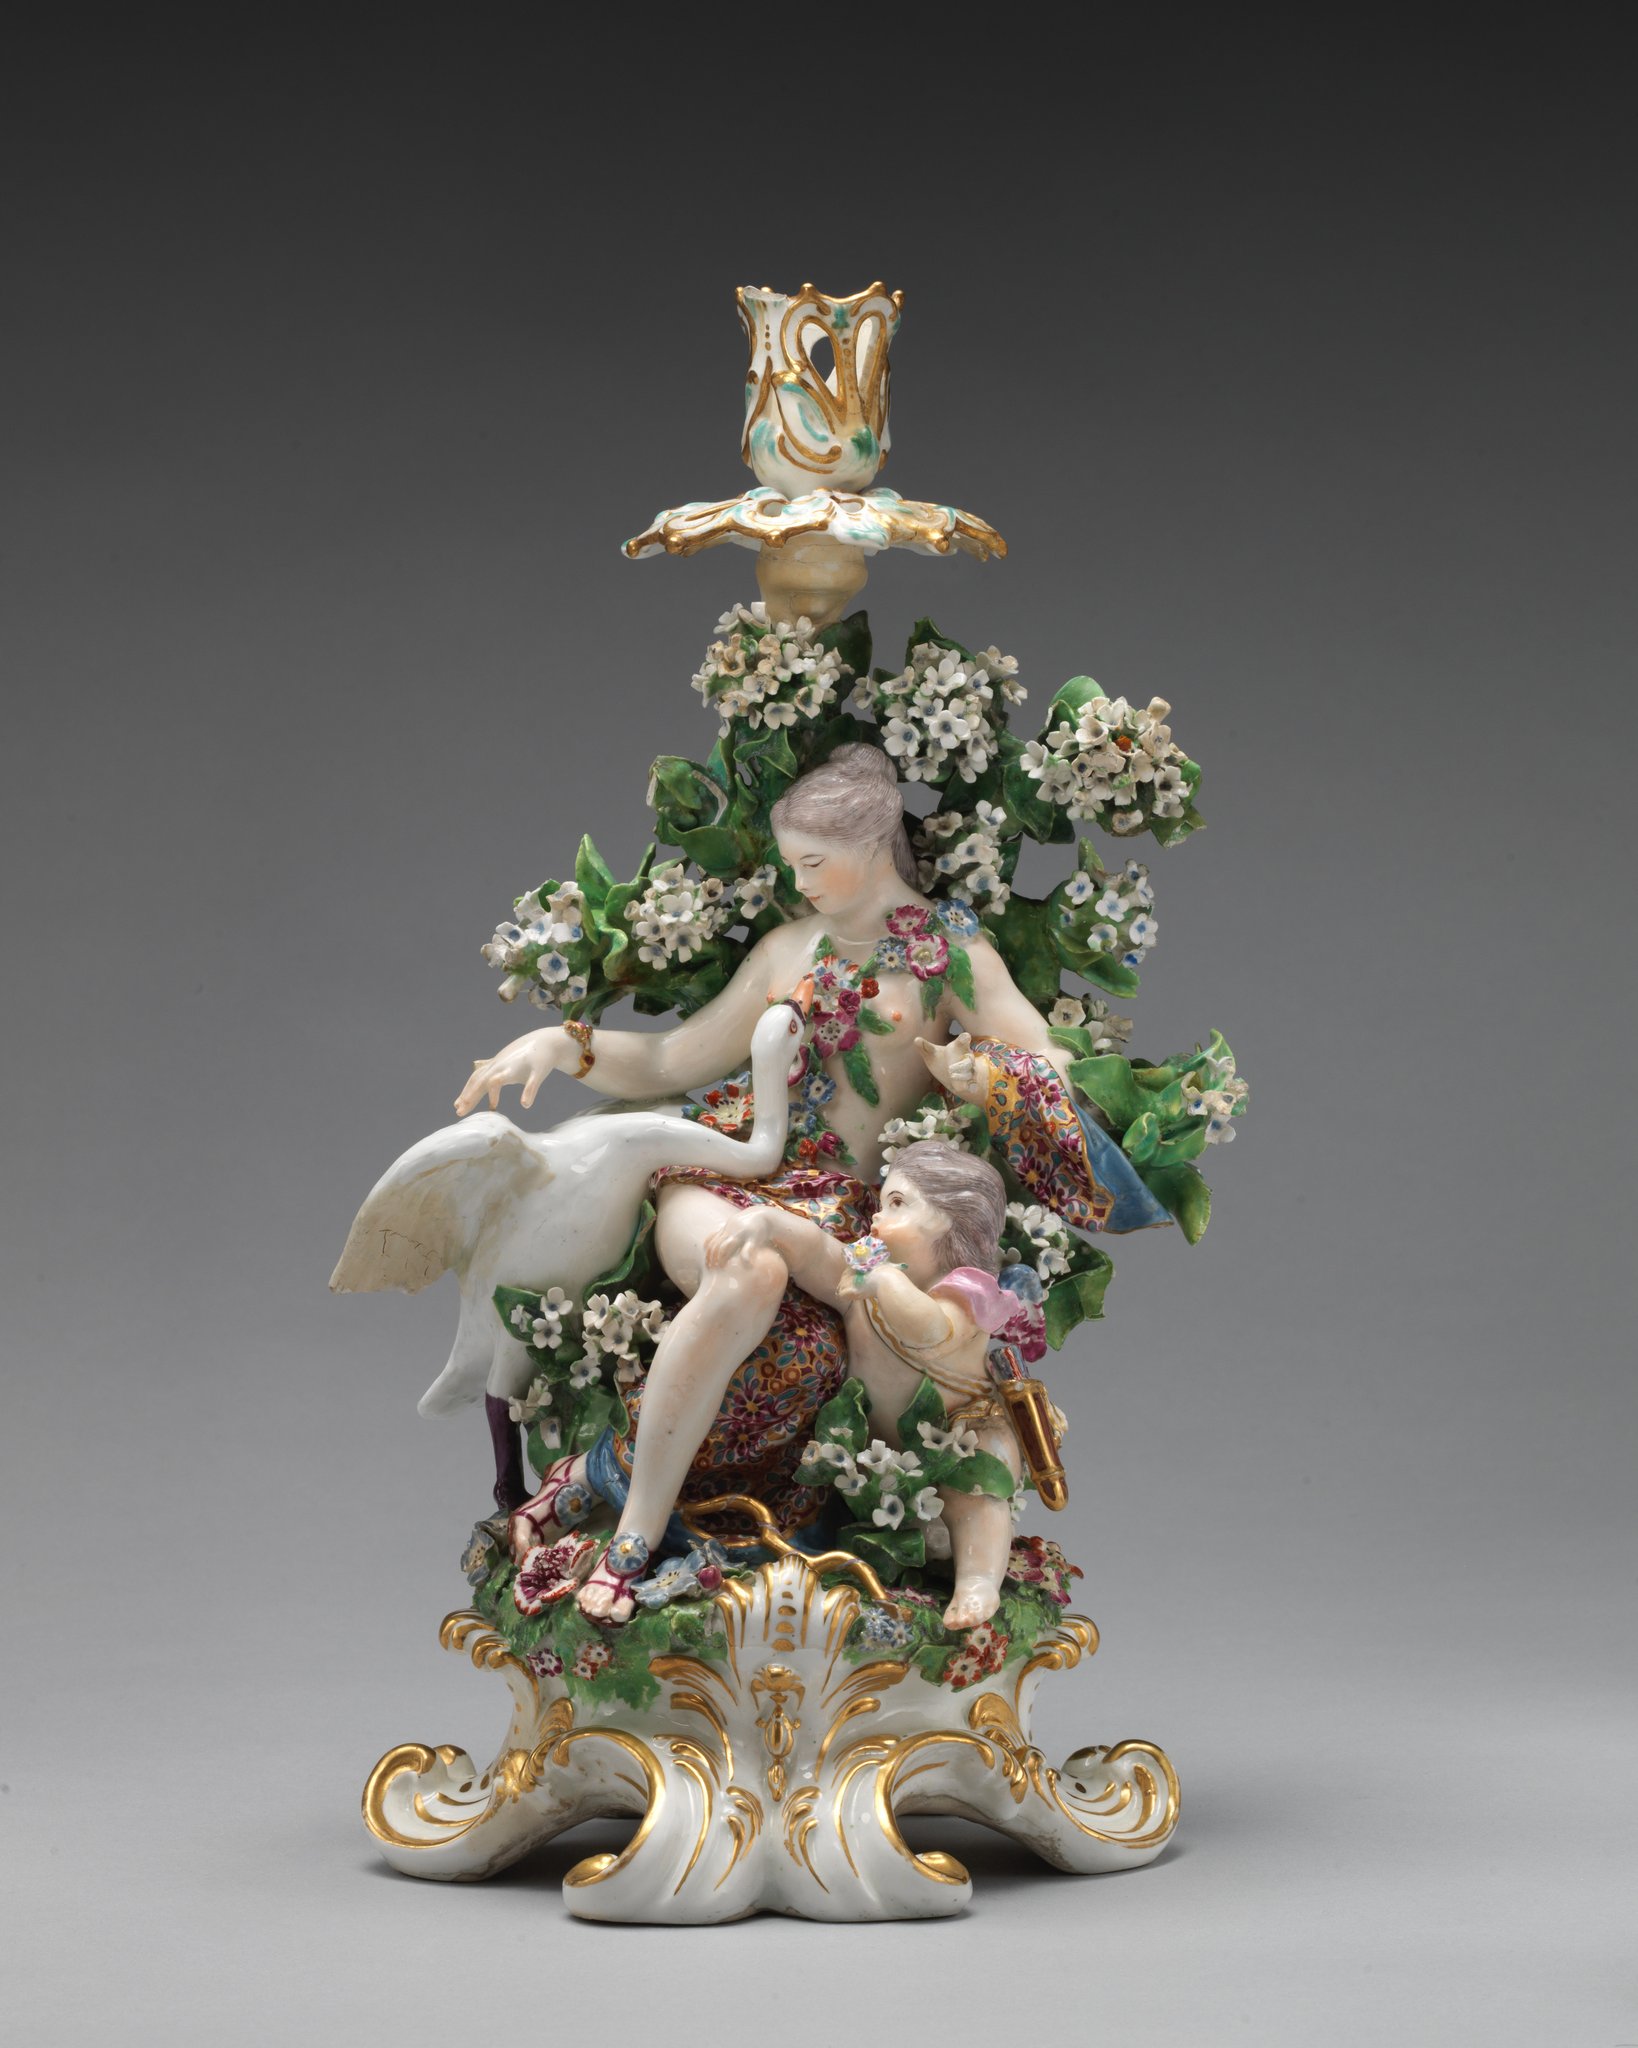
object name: candlestick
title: Venus, Cupid and the Swan candlestick (one of a pair)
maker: chelsea porcelain manufactory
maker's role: factory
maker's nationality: british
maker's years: 1744-1784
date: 1765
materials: soft paste porcelain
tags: cupid,venus,swans